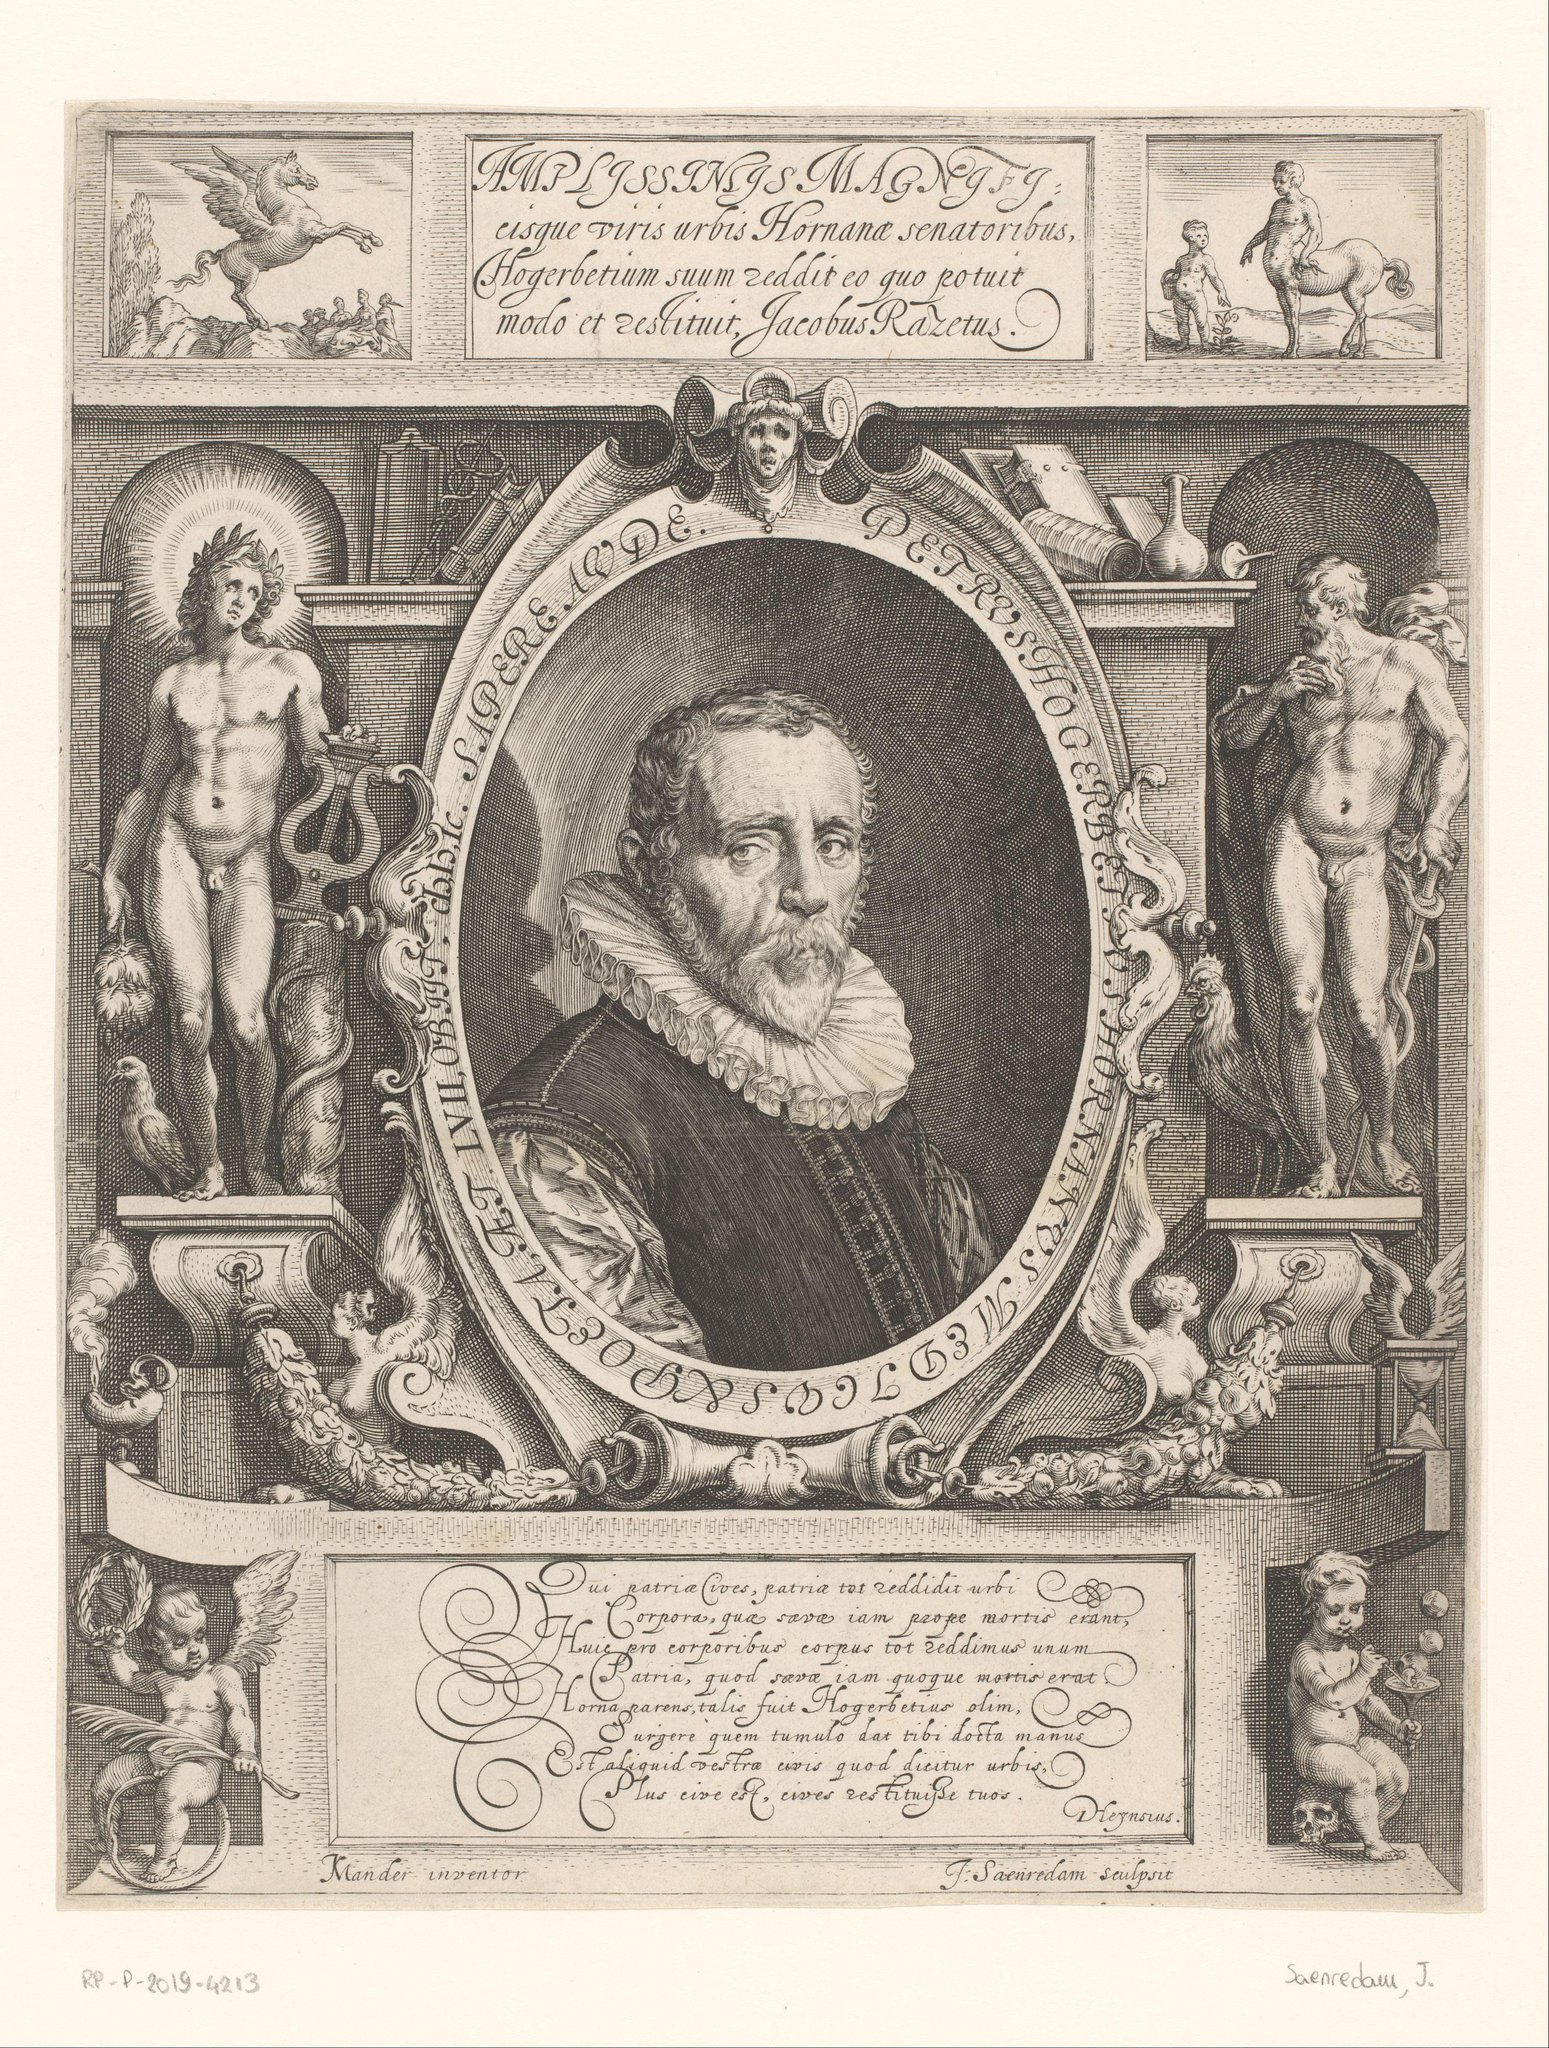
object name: print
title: Portret van Petrus Hogerbeets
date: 1599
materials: paper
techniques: engraving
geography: amsterdam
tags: hoorn (north holland), petrus hogerbeets, apollo medicus, aesculapius instructed by chiron, historical persons, aesculapius as patron of medicine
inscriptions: collector's mark: Lugt 4617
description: Buste naar rechts van de arts en dichter Petrus Hogerbeets in een ovale omlijsting met een Latijnse randtekst, die informatie bevat over de geportretteerde. Links staat Apollo als Apollo Medicus op een console bij een zuil met een slang. Hij houdt een harp vast. Bij zijn rechtervoet een kraai, die over Coronis had moeten waken. Rechts staat Aesculapius bij een haan op een console. Hij houdt een esculaap vast. Boven de lijst medische instrumenten en boeken. Linksboven Pegasus die de Hippocrene doet ontspringen. Rechts de jonge Aesculapius bij de centaur Chiron, die hem heeft opgevoed. Tussen deze voorstellingen staat een Latijnse tekst met informatie over de geportretteerde. Linksonder en putto met een lauwerkrans, een palmtak en een slang die in zijn eigen staart bijt als symbool van eeuwigheid. Rechtsonder een putto op een schedel, die bellen blaast als vanitassymbool. Tussen de putti een achtregelige, Latijnse tekst.